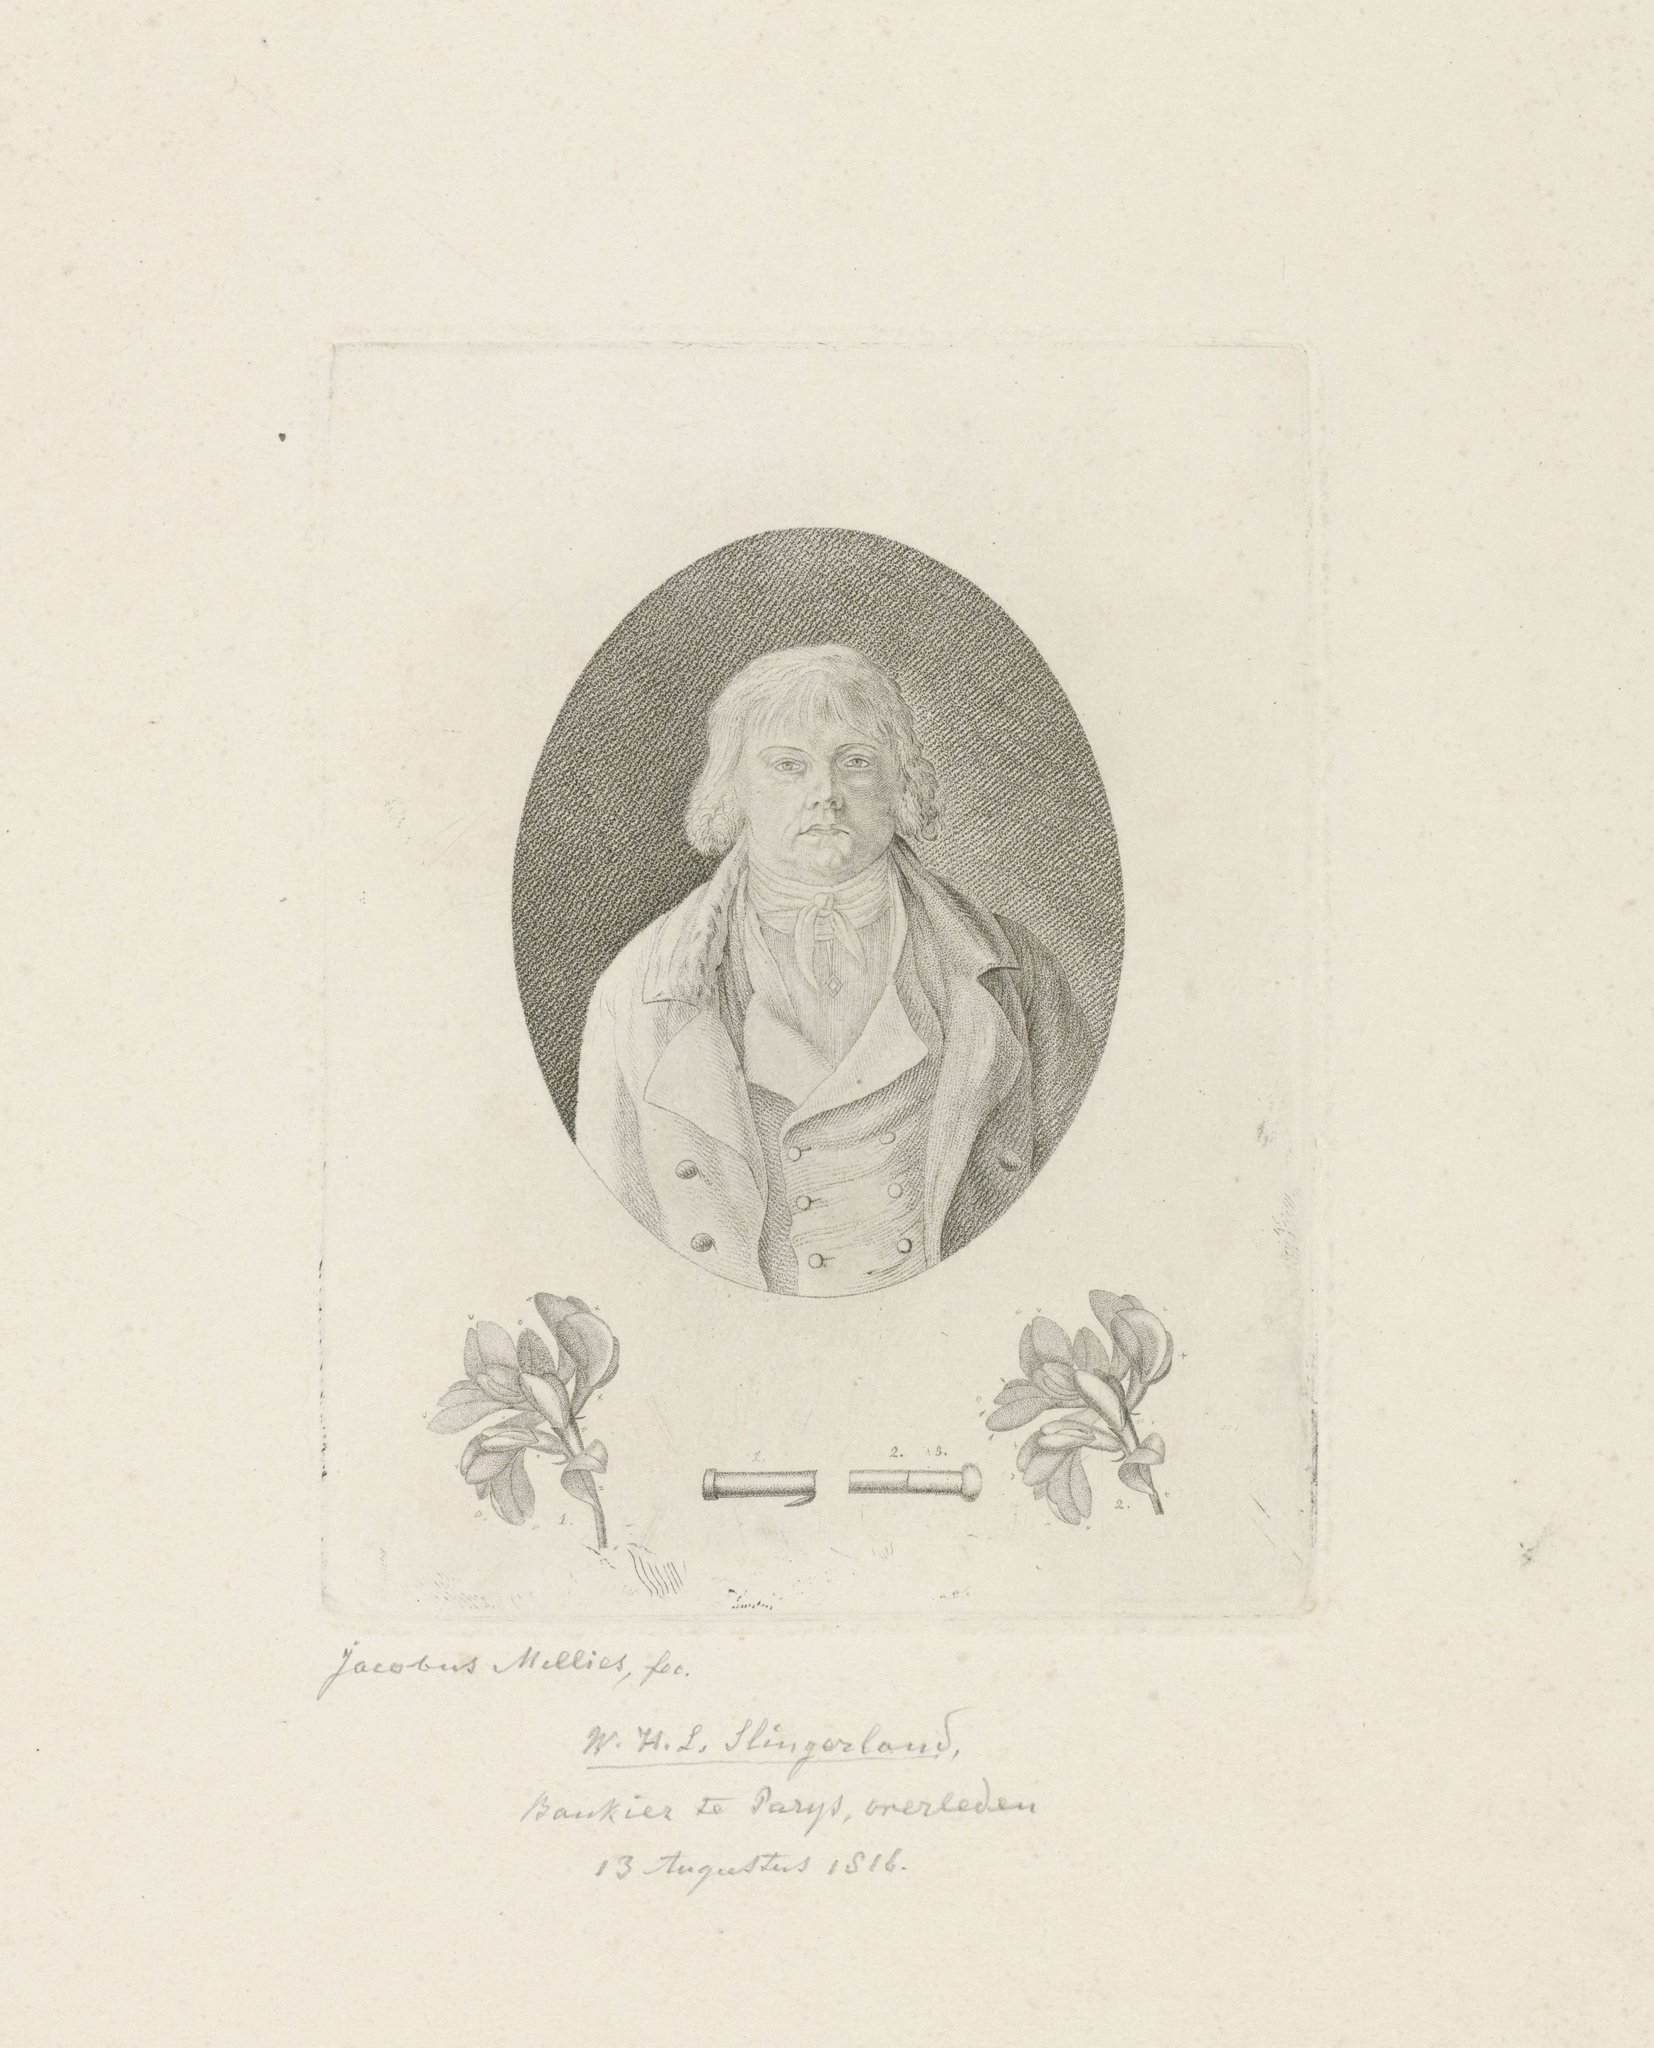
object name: print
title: Portret van W.H.L. Slingerland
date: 1777-1813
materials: paper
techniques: etching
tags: bankier, w.h.l. slingerland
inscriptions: inscription: ‘Het hier achter staande portret, was de zwager, van den vervaardiger daarvan, Jacobus Millies. Deze zijn zoon, H.C. Millies, Hoogleeraar te Utrecht, heeft mij dit geschonken - P. Kram.’, collector's mark: Lugt 2228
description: Portret van W.H.L. Slingerland, bankier te Parijs en de zwager van de prentmaker. Onderaan in de marge twee genummerde bloemen en een langwerpig voorwerp.